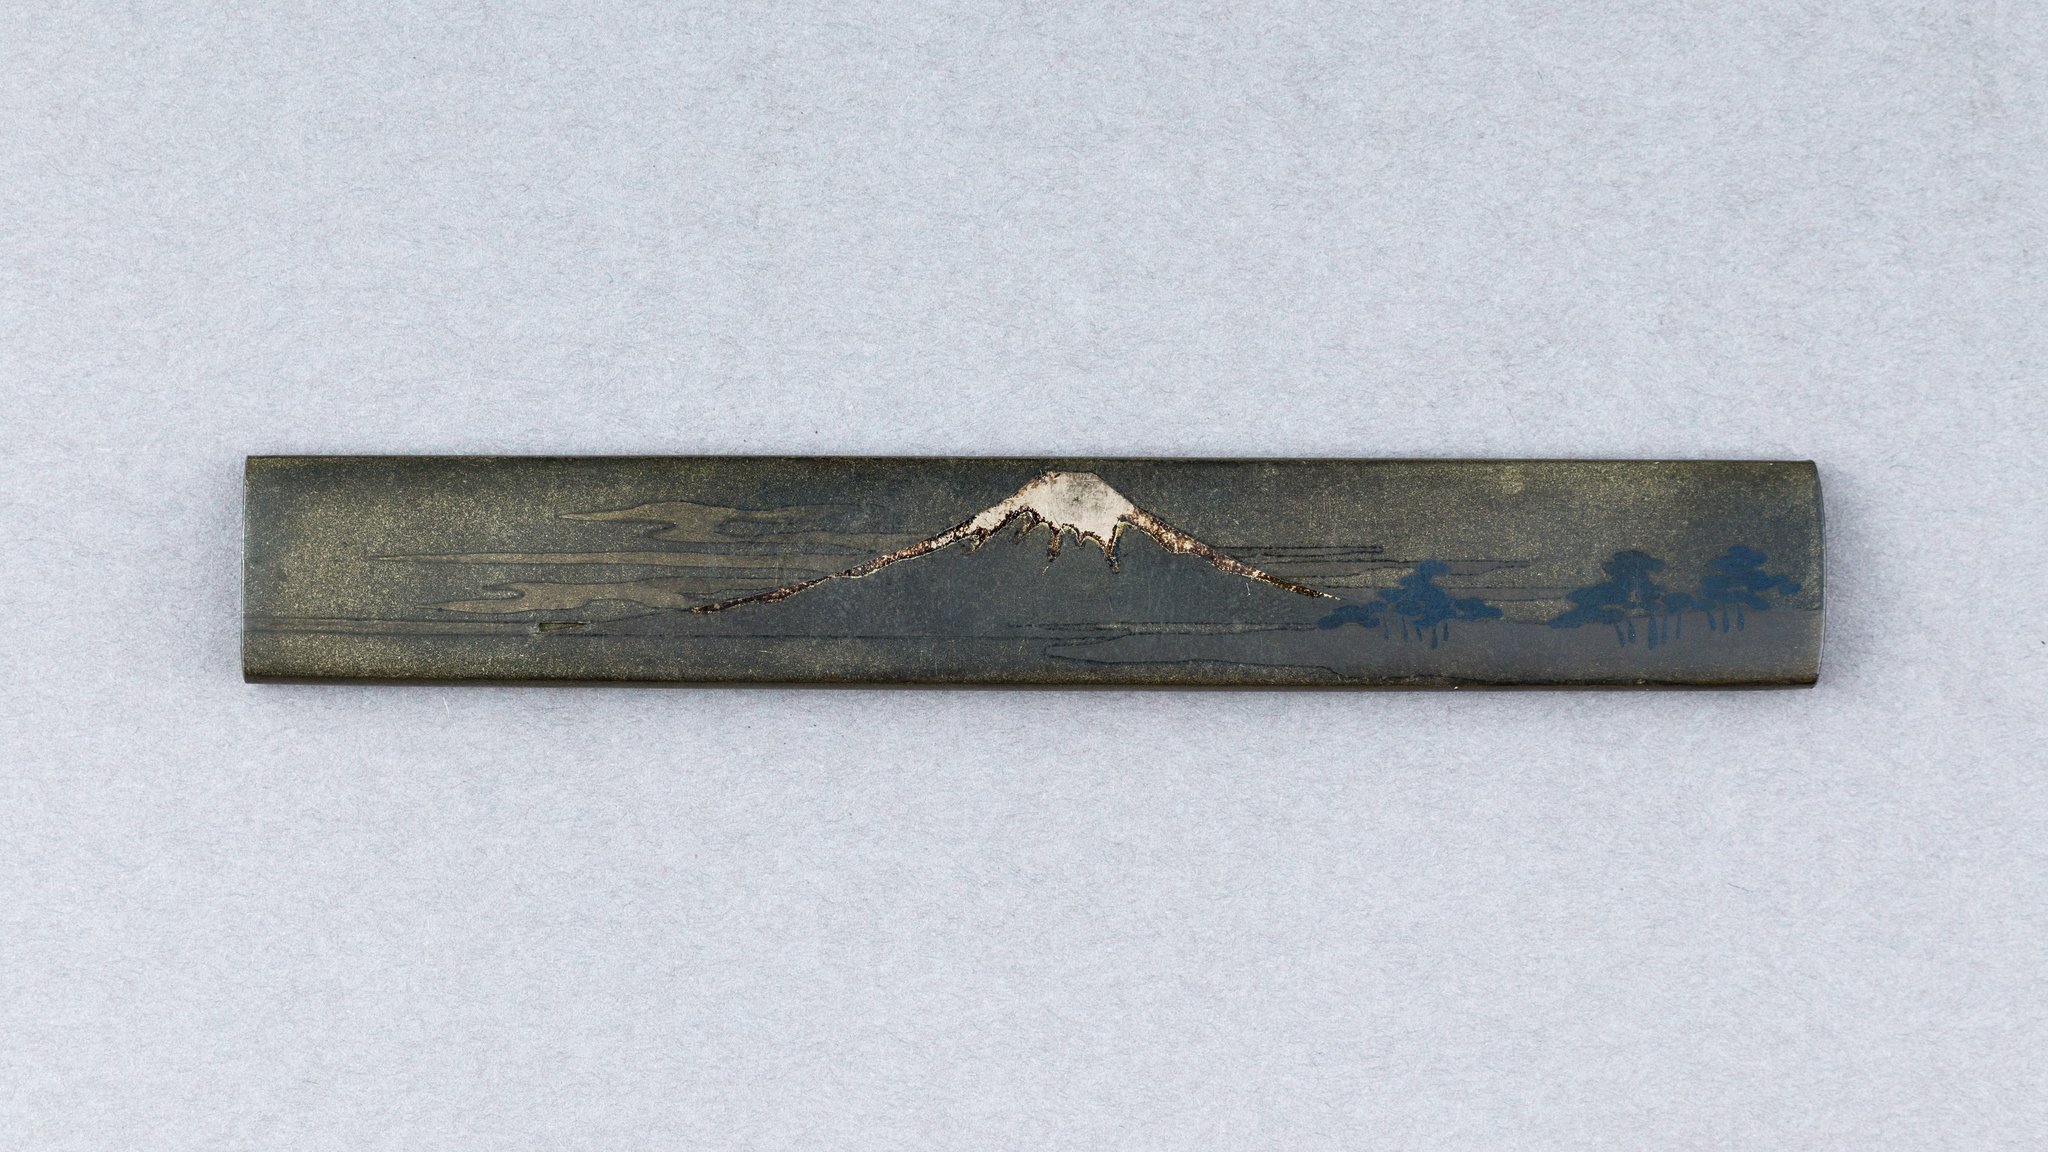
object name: knife handle kozuka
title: Knife Handle (Kozuka)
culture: japanese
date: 1615-1868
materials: gold alloy, silver alloy, silver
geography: japan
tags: mountains